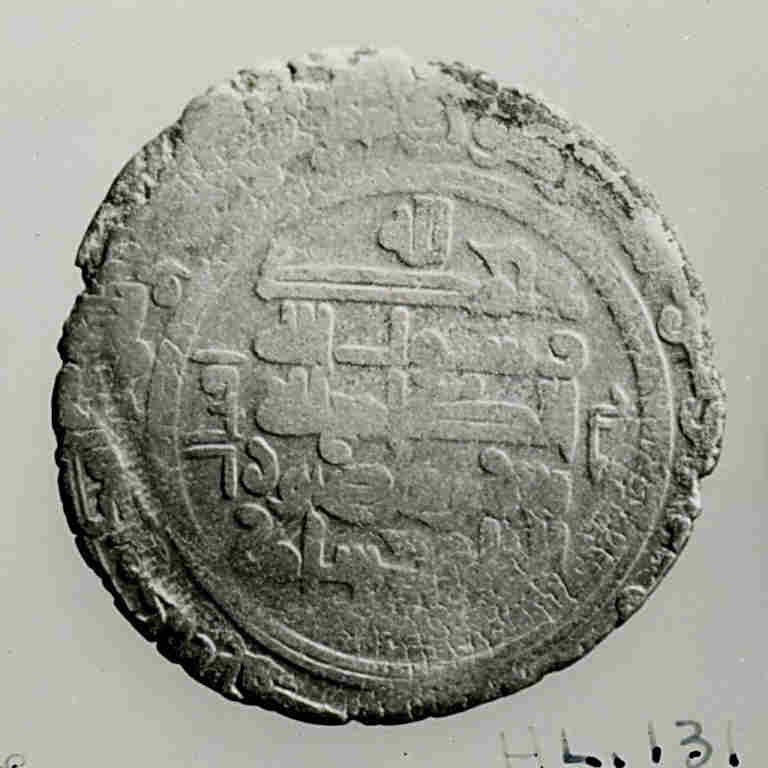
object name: coin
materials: silver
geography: iran